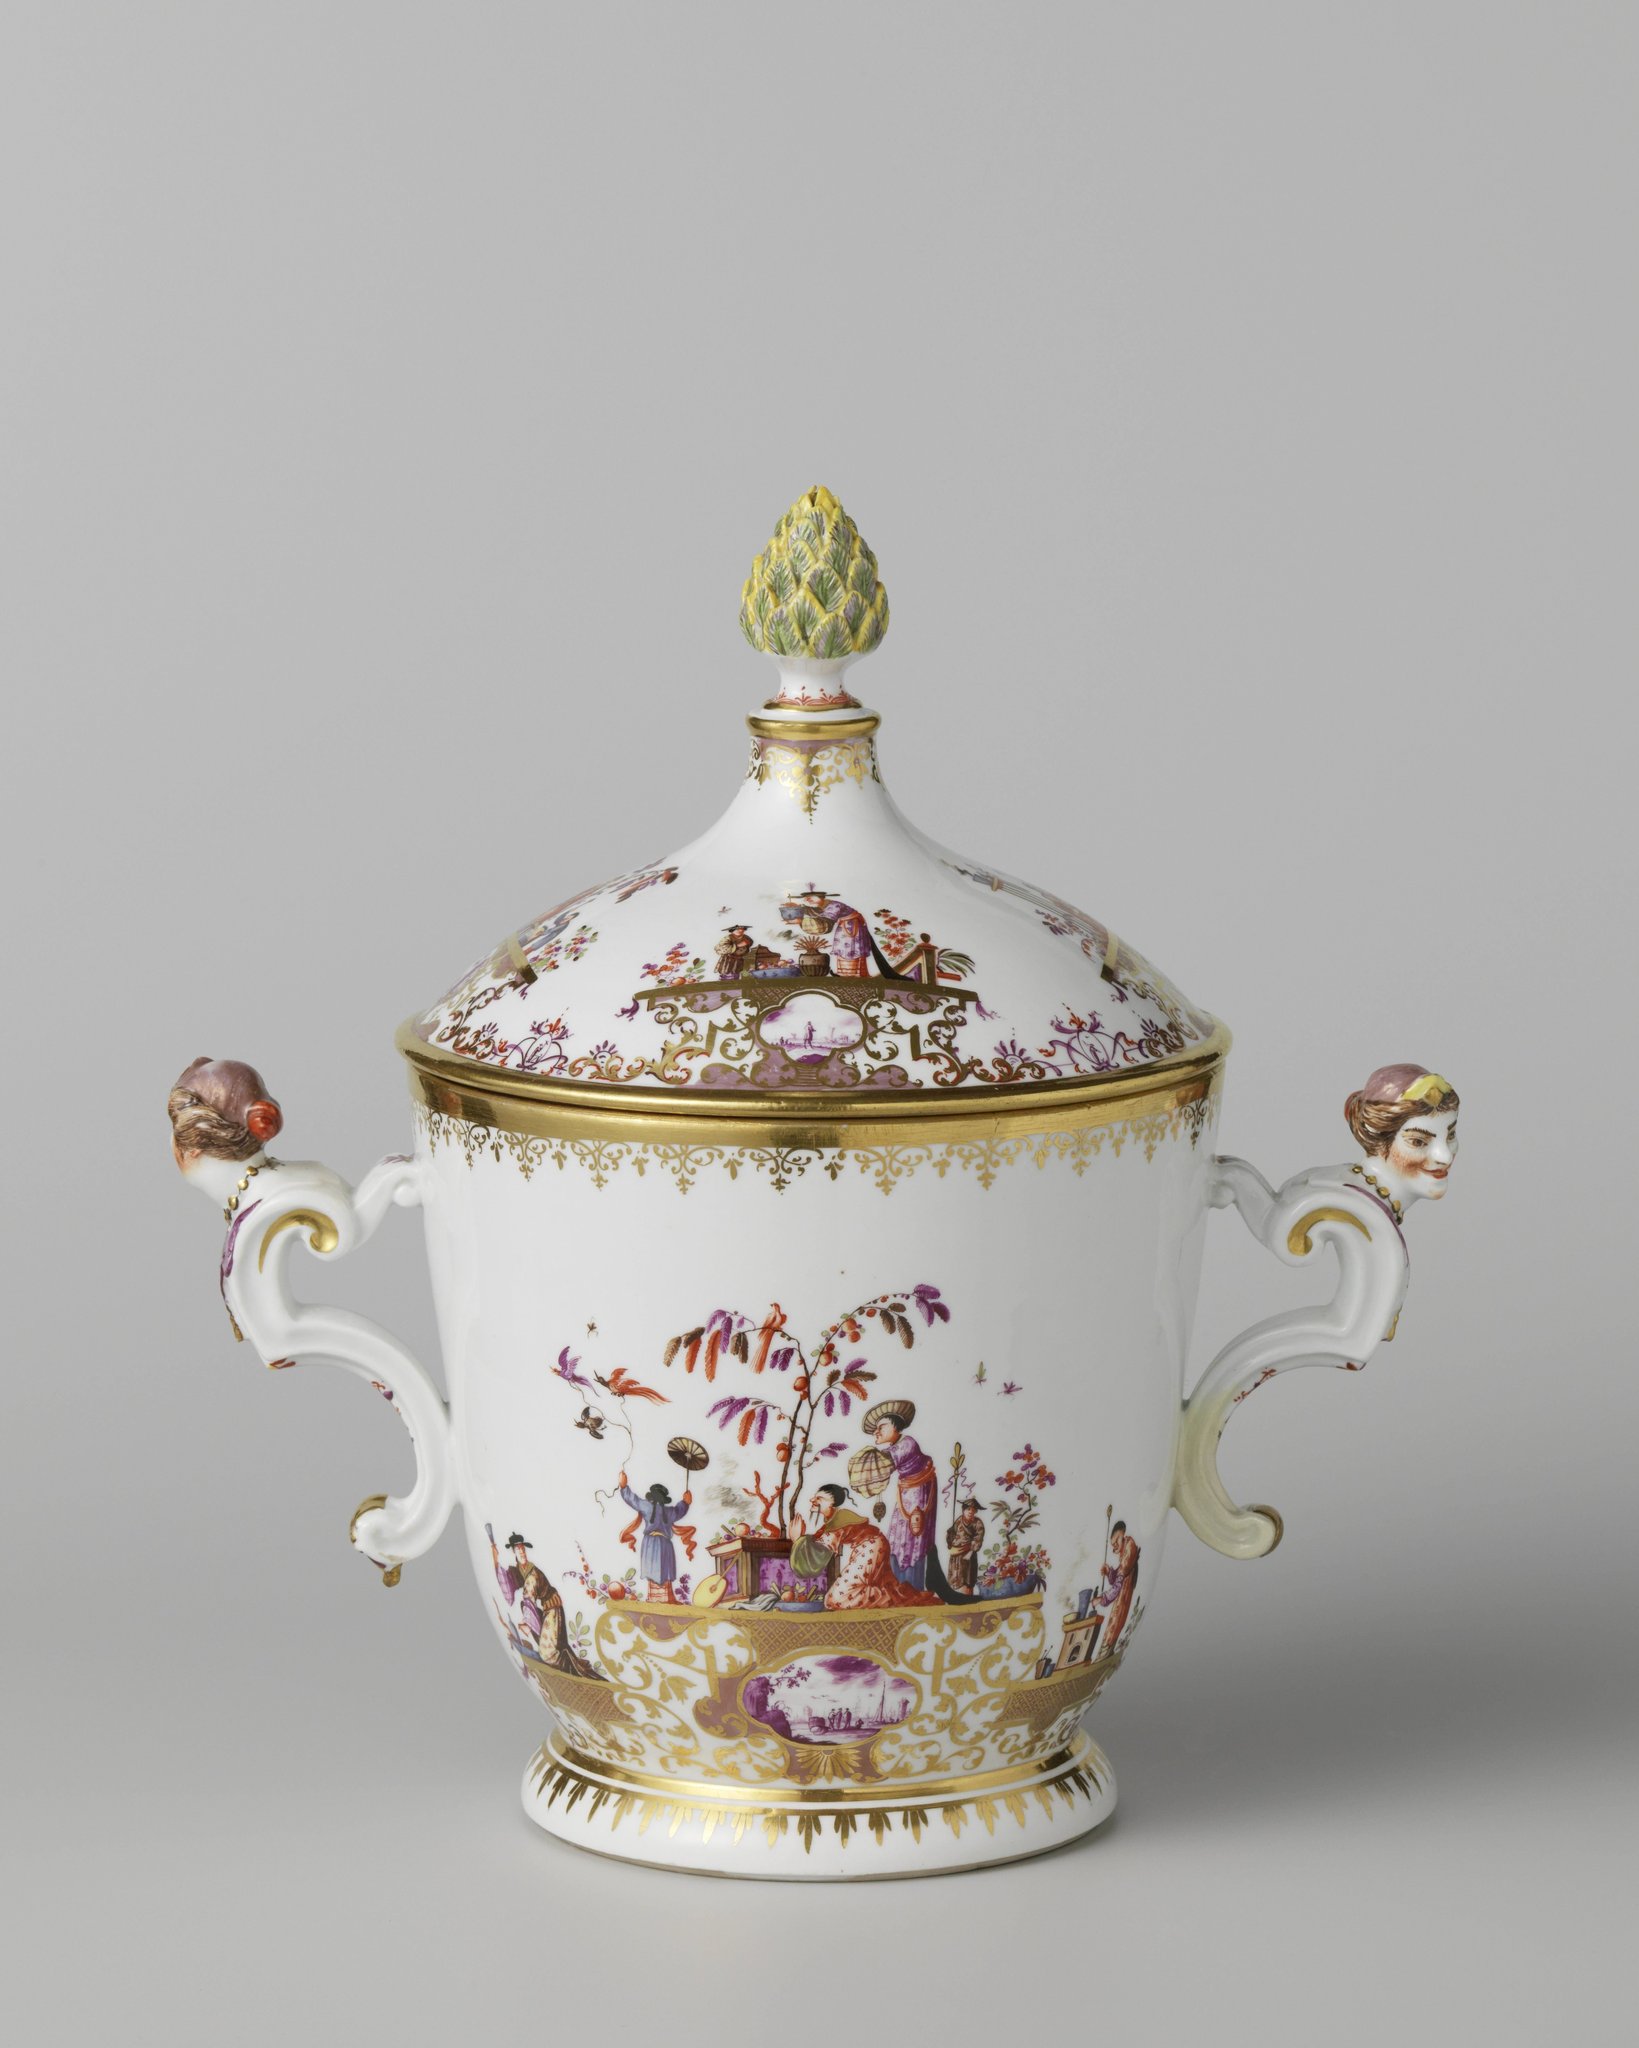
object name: tureen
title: Terrine, veelkleurig beschilderd met chinoiserieën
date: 1730-1735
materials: porcelain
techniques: painted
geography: meissen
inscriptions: factory mark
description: Terrine van beschilderd porselein. De terrine heeft twee voluutvormige oren bekroond door een vrouwenkop, met onderaan een verguld acanthusblad in reliëf. Het deksel eindigt in een artisjok. De terrine is versierd met twee. De terrine is gemerkt.